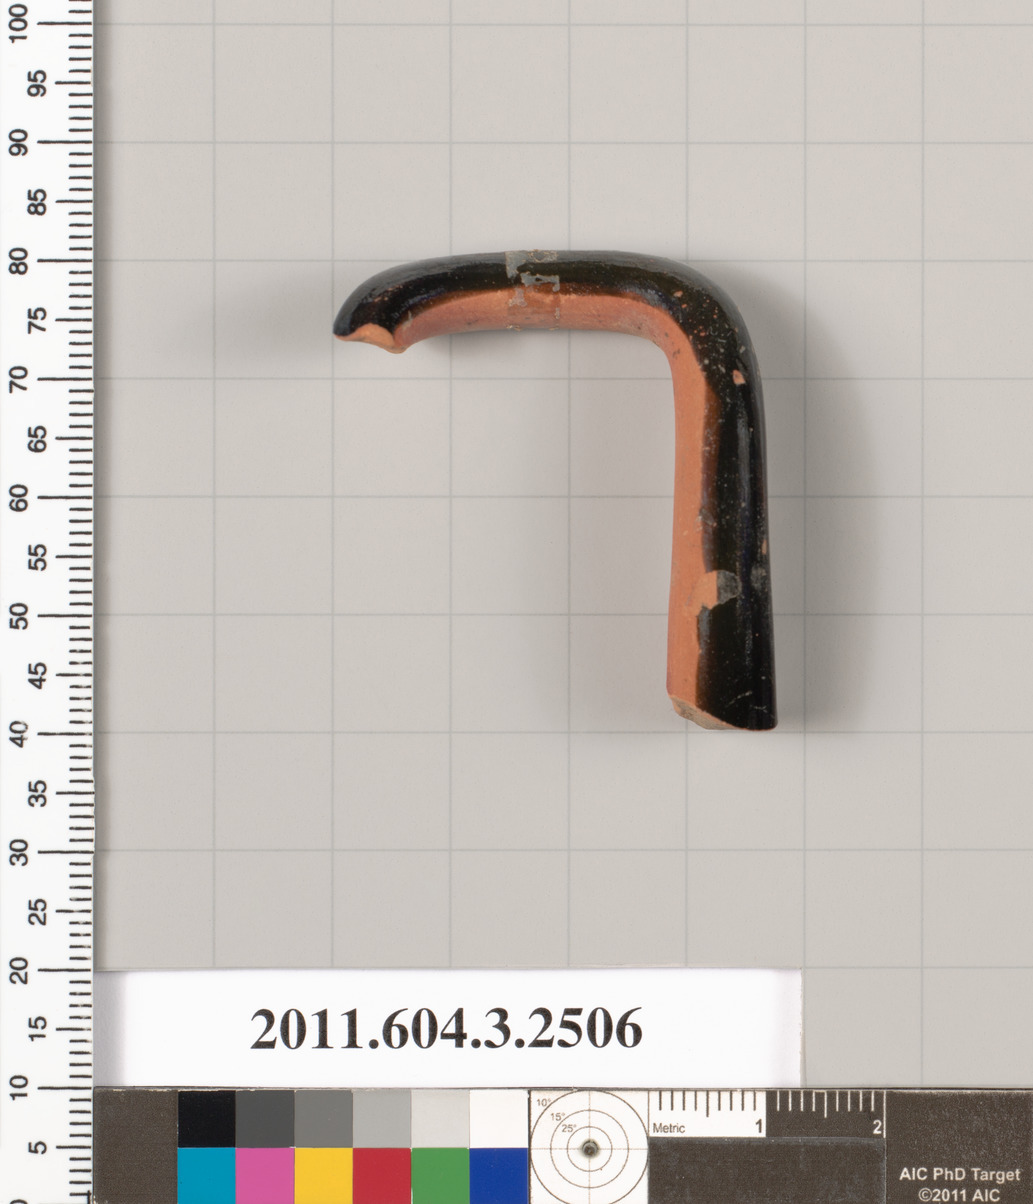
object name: kylix fragment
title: Terracotta fragment of a kylix (drinking cup)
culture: greek, attic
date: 600-401 BCE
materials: terracotta